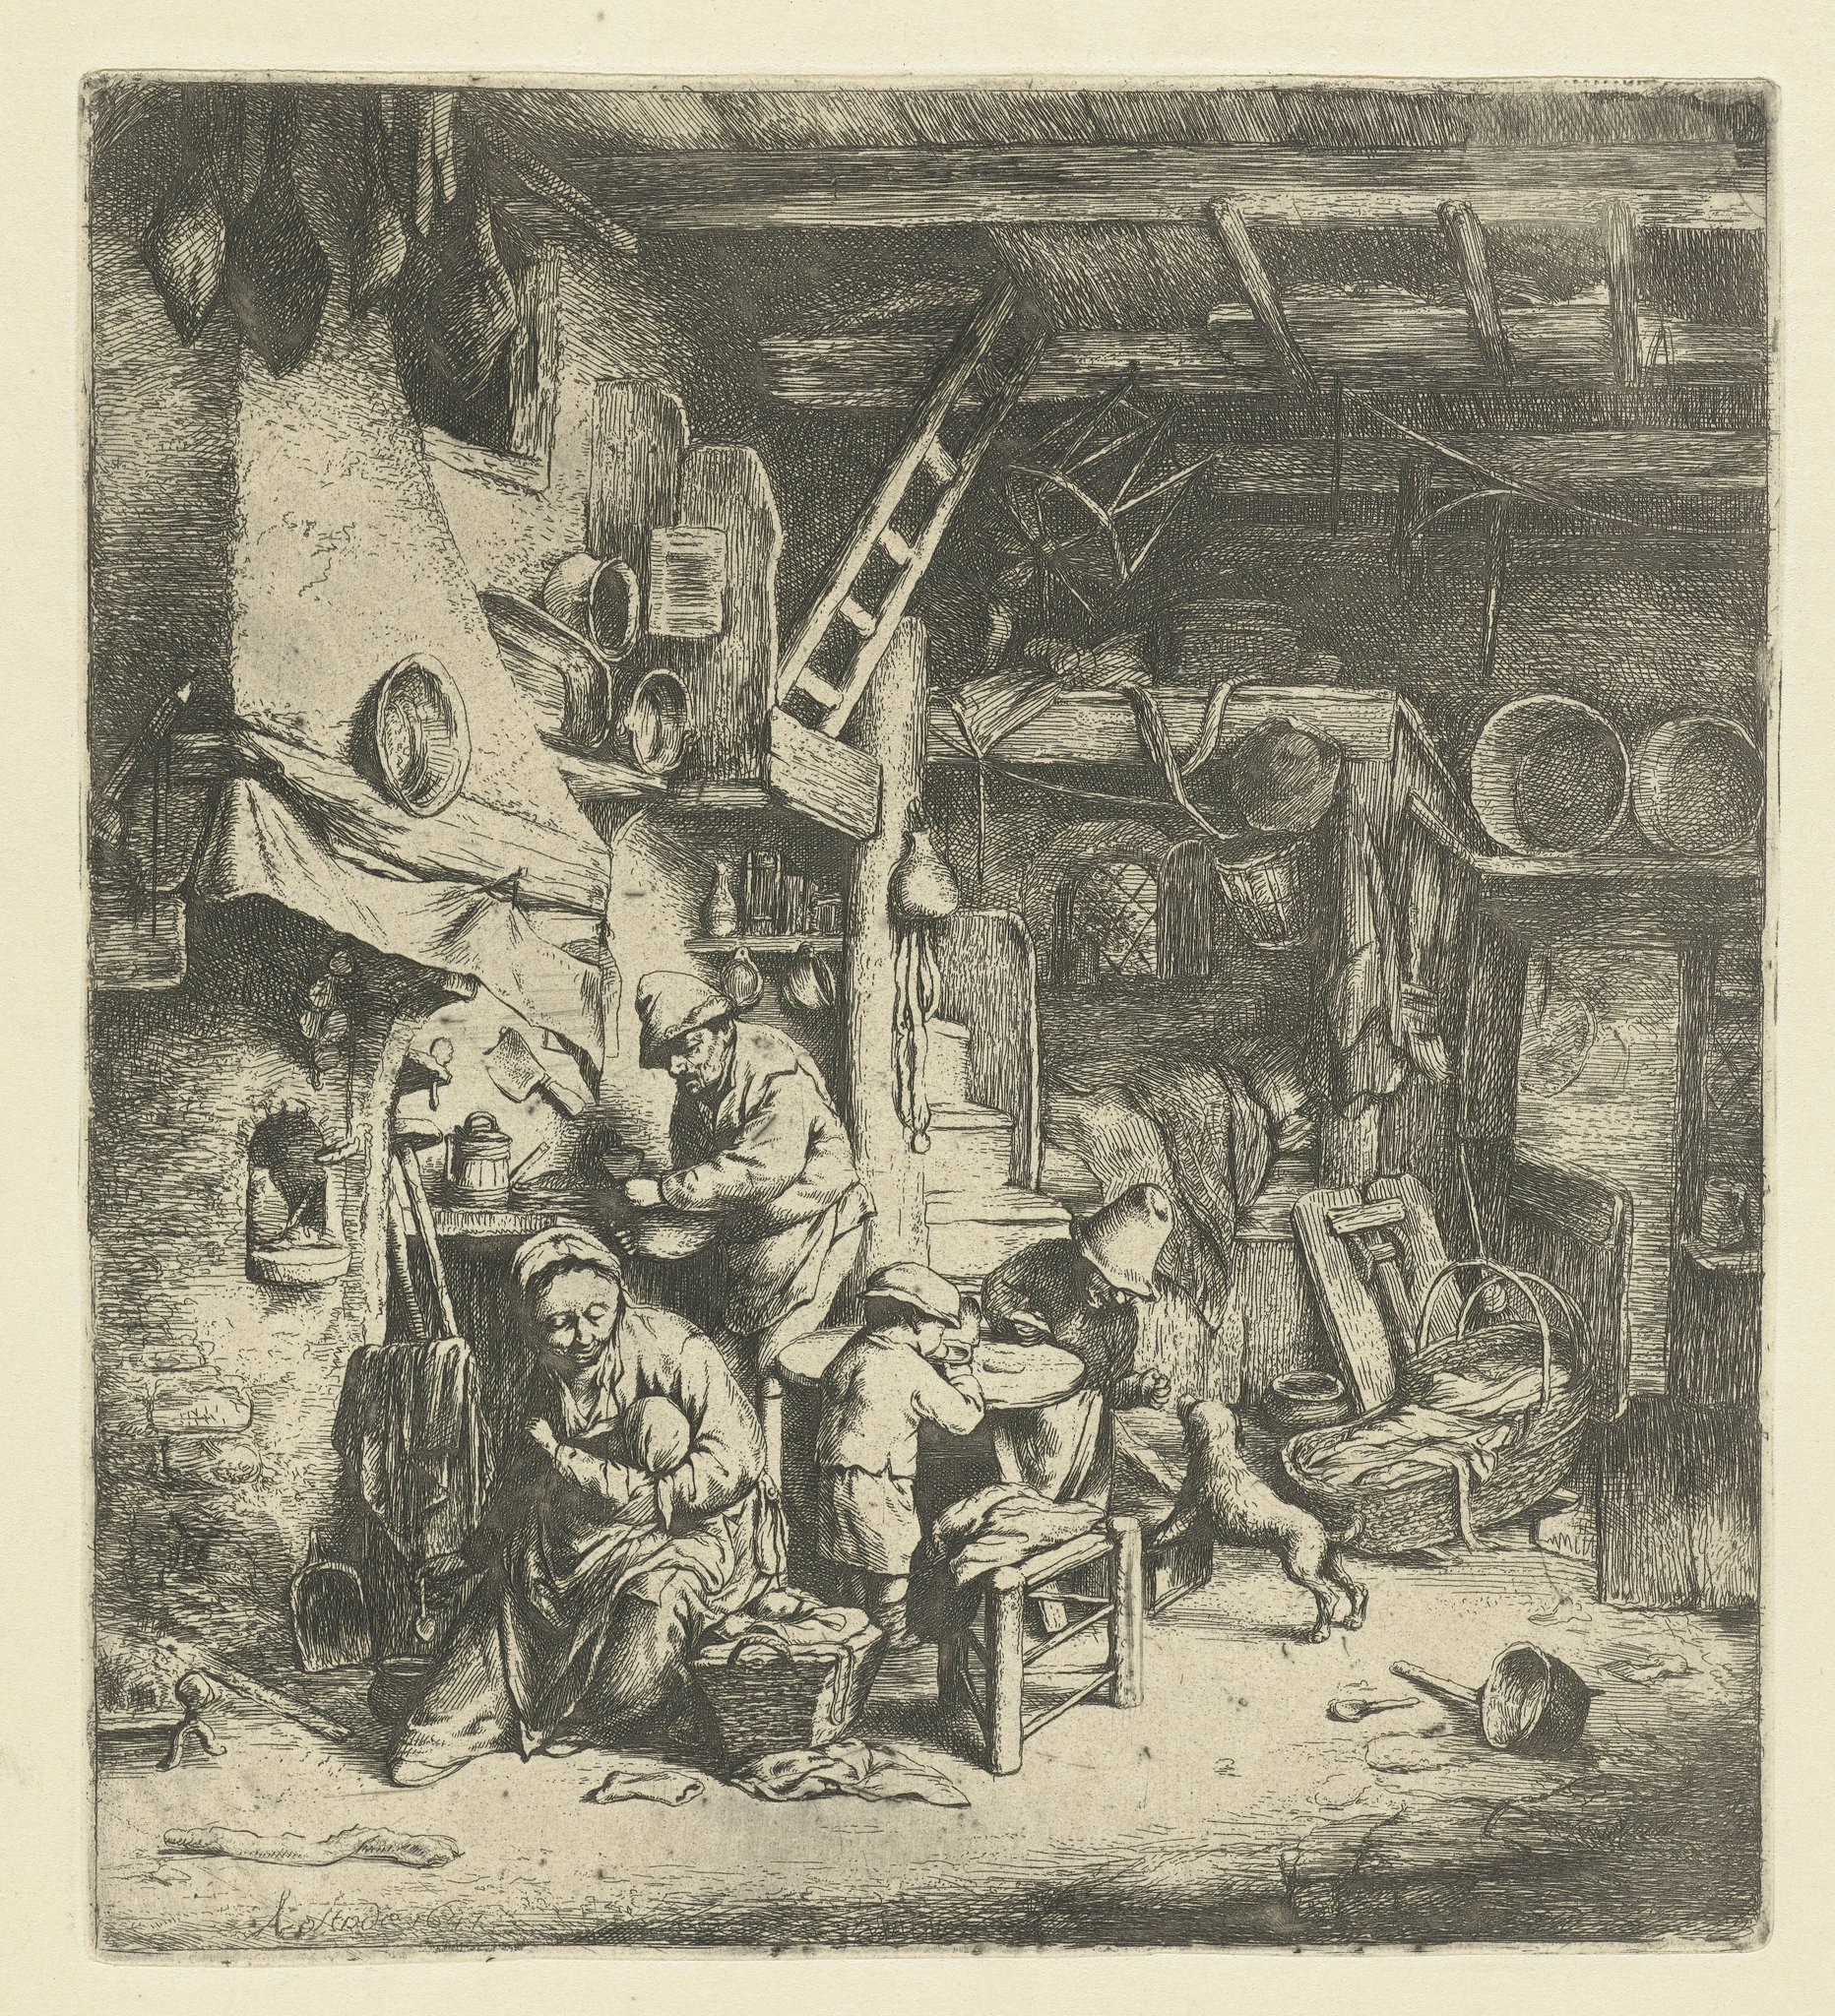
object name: print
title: Het boerenhuishouden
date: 1647-1745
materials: paper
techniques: etching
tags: family life, interior of the house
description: Kopie naar prent van Adriaen van Ostade waarin de originele voorstelling vrij nauwkeurig is gevolgd maar wel spiegelverkeerd is weergegeven.